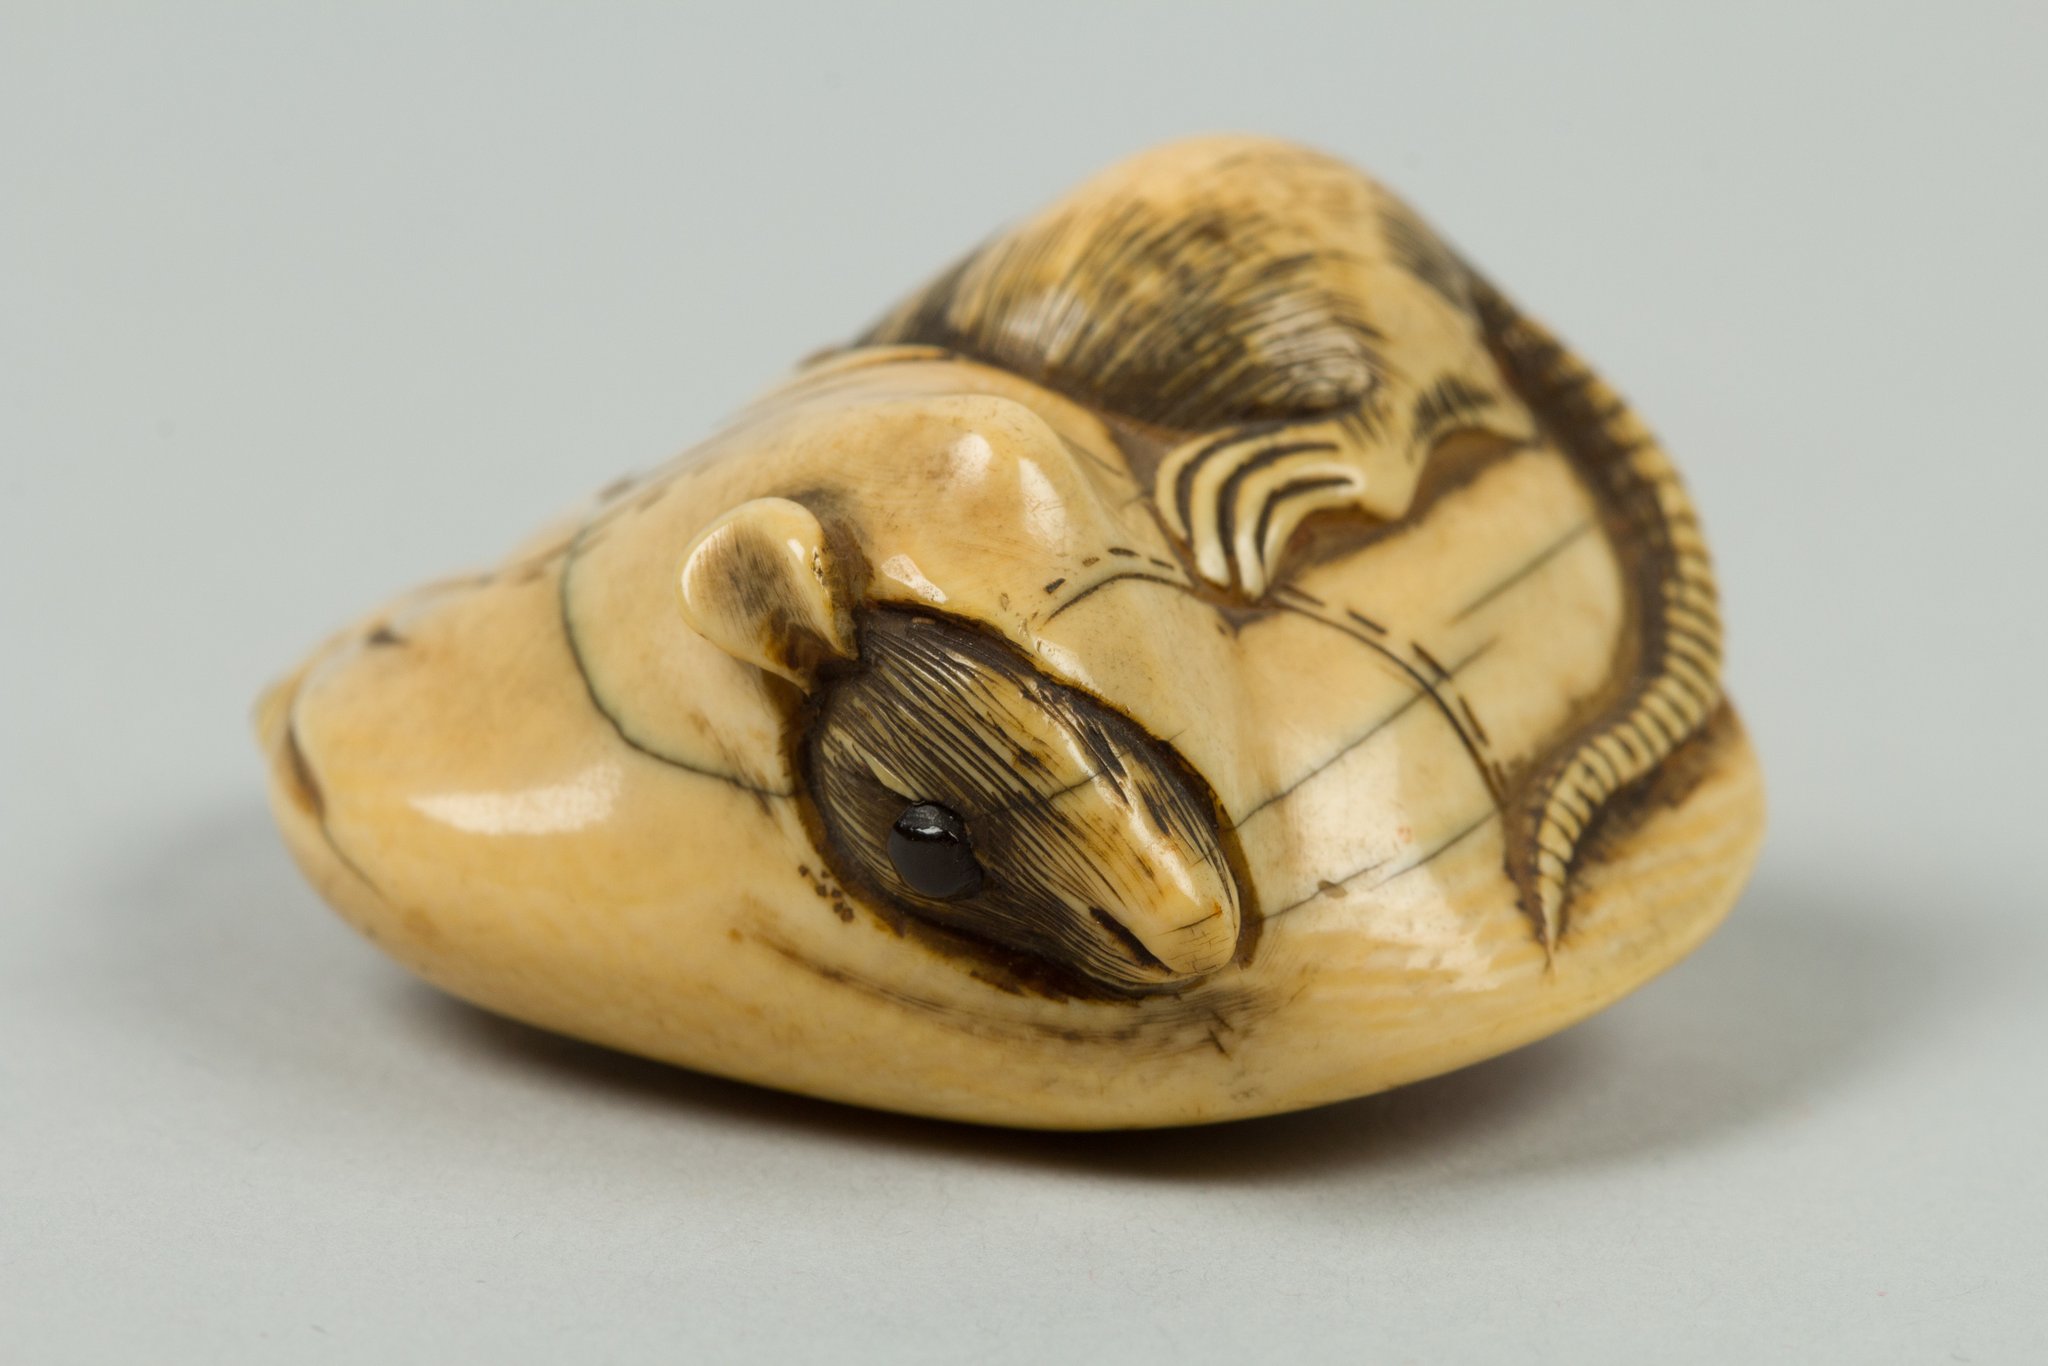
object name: netsuke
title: Netsuke of Mouse in a Bag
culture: japanese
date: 1801-1900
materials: ivory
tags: mice